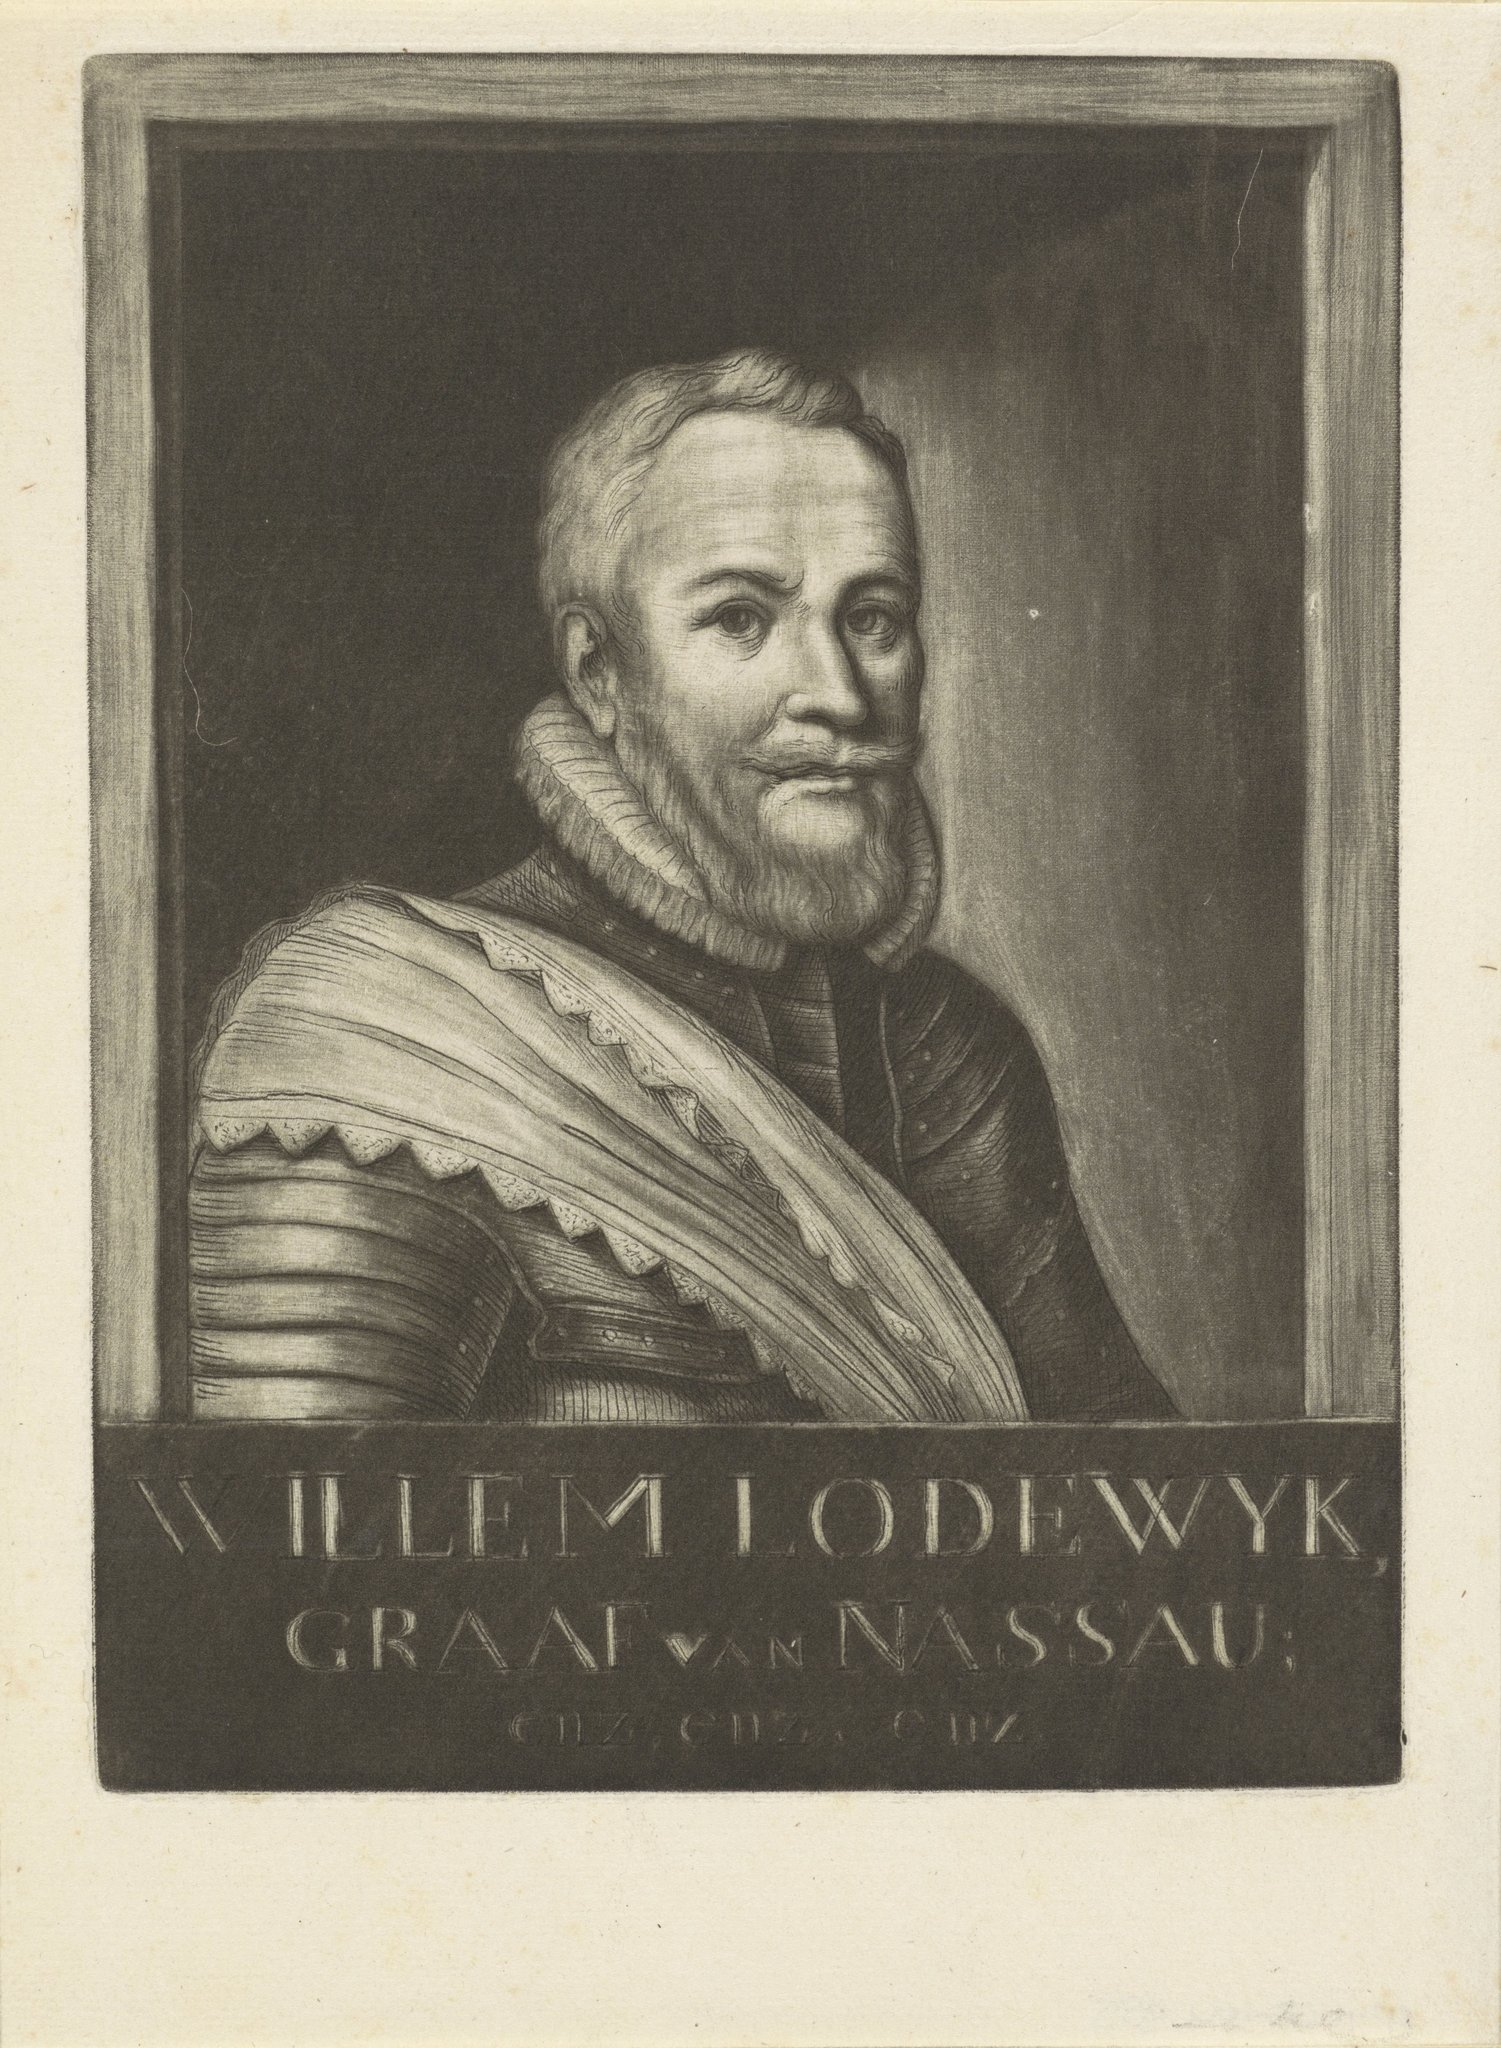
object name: book illustration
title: Portret van Willem Lodewijk, graaf van Nassau-Dillenburg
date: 1770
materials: paper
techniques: etching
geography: leeuwarden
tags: willem lodewijk graaf van nassau-dillenburg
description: De hier vermelde titel verwijst naar de hoogst verkregen titel van de geportretteerde, niet per se naar de titel die de geportretteerde op deze voorstelling draagt. Prent uit: Bosch, Johannes van den. De heeren stadhouderen van Vriesland, zedert den jare acht-hondert, volgens hoogst derzelver successie kortelyk beschreven. Leeuwarden: Abraham Ferwerda en Gerrit Tresling, 1770.